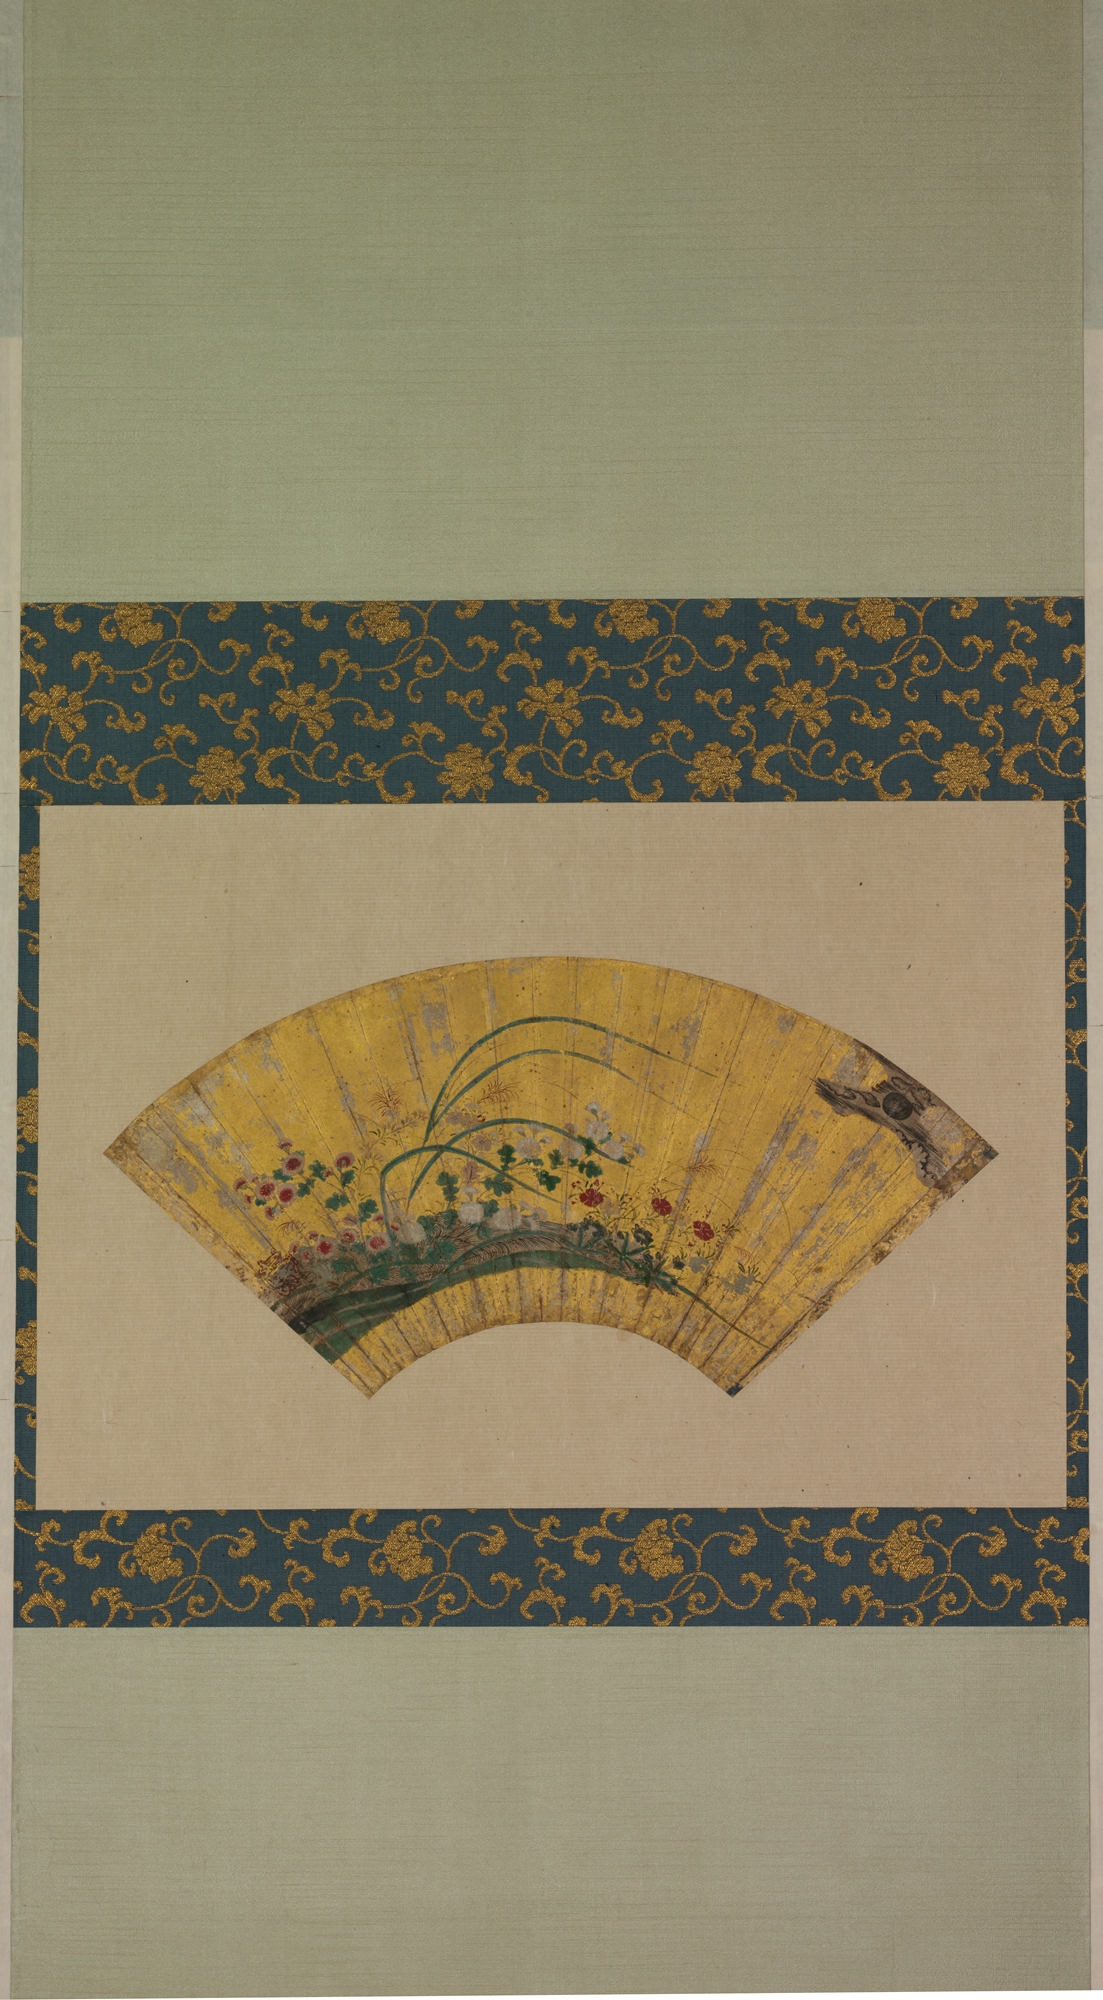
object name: hanging scroll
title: Moon over an Autumn Moor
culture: japanese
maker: kano yukinobu 狩野之信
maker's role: artist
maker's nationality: japanese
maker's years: 1513-1575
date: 1501-1600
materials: ink, paper, silver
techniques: gilding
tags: flowers